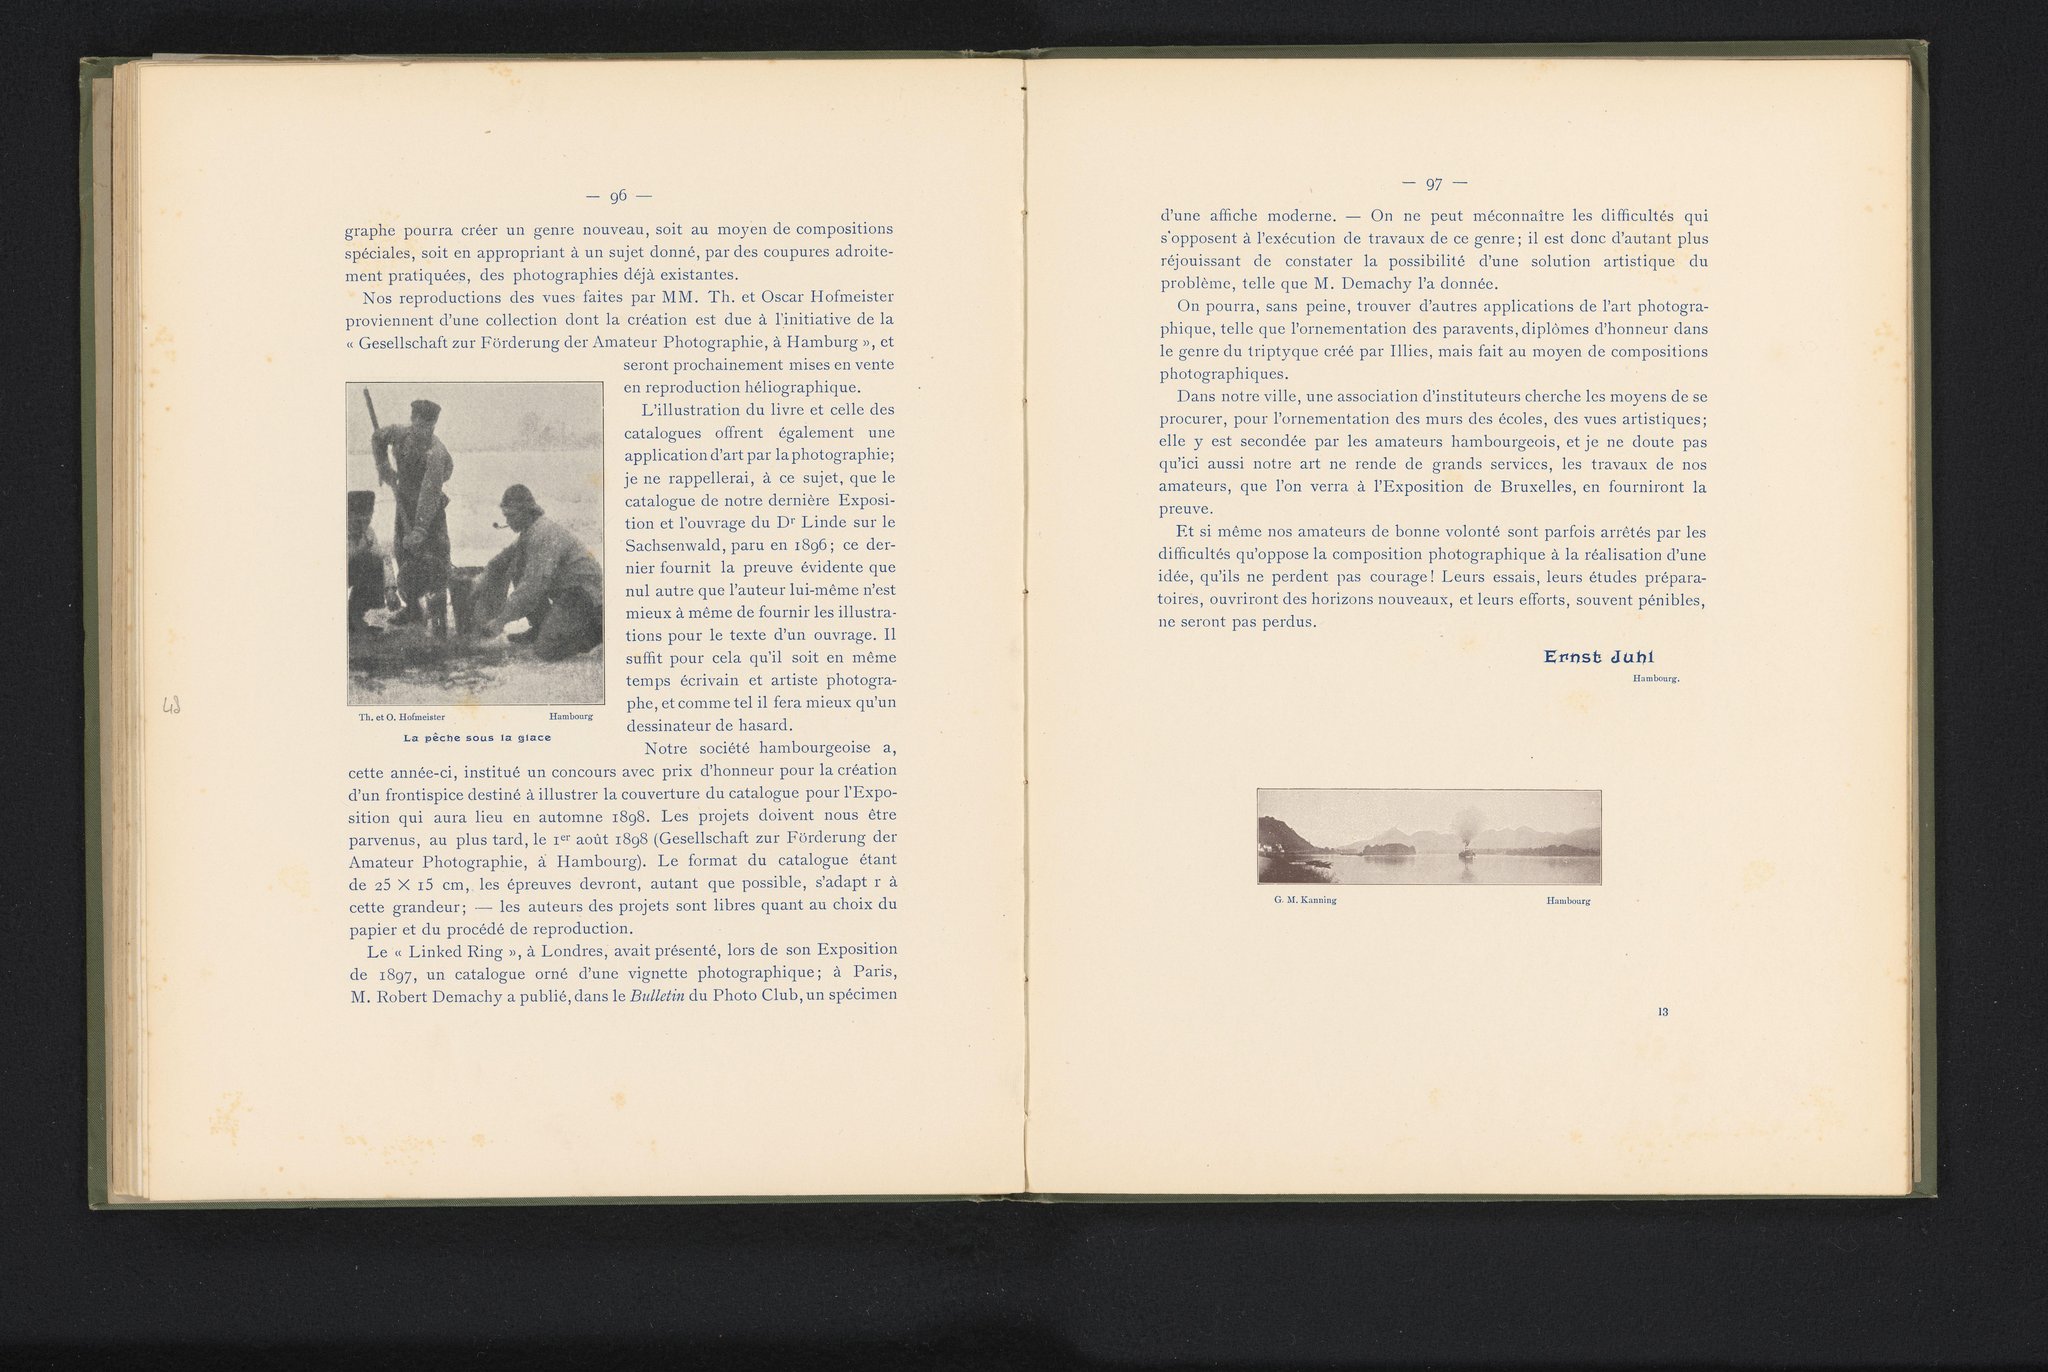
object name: page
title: Stoomboot op een meer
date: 1893-1898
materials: paper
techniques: autotype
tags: lake, steamship, motorship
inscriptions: inscription: ‘Hambourg’